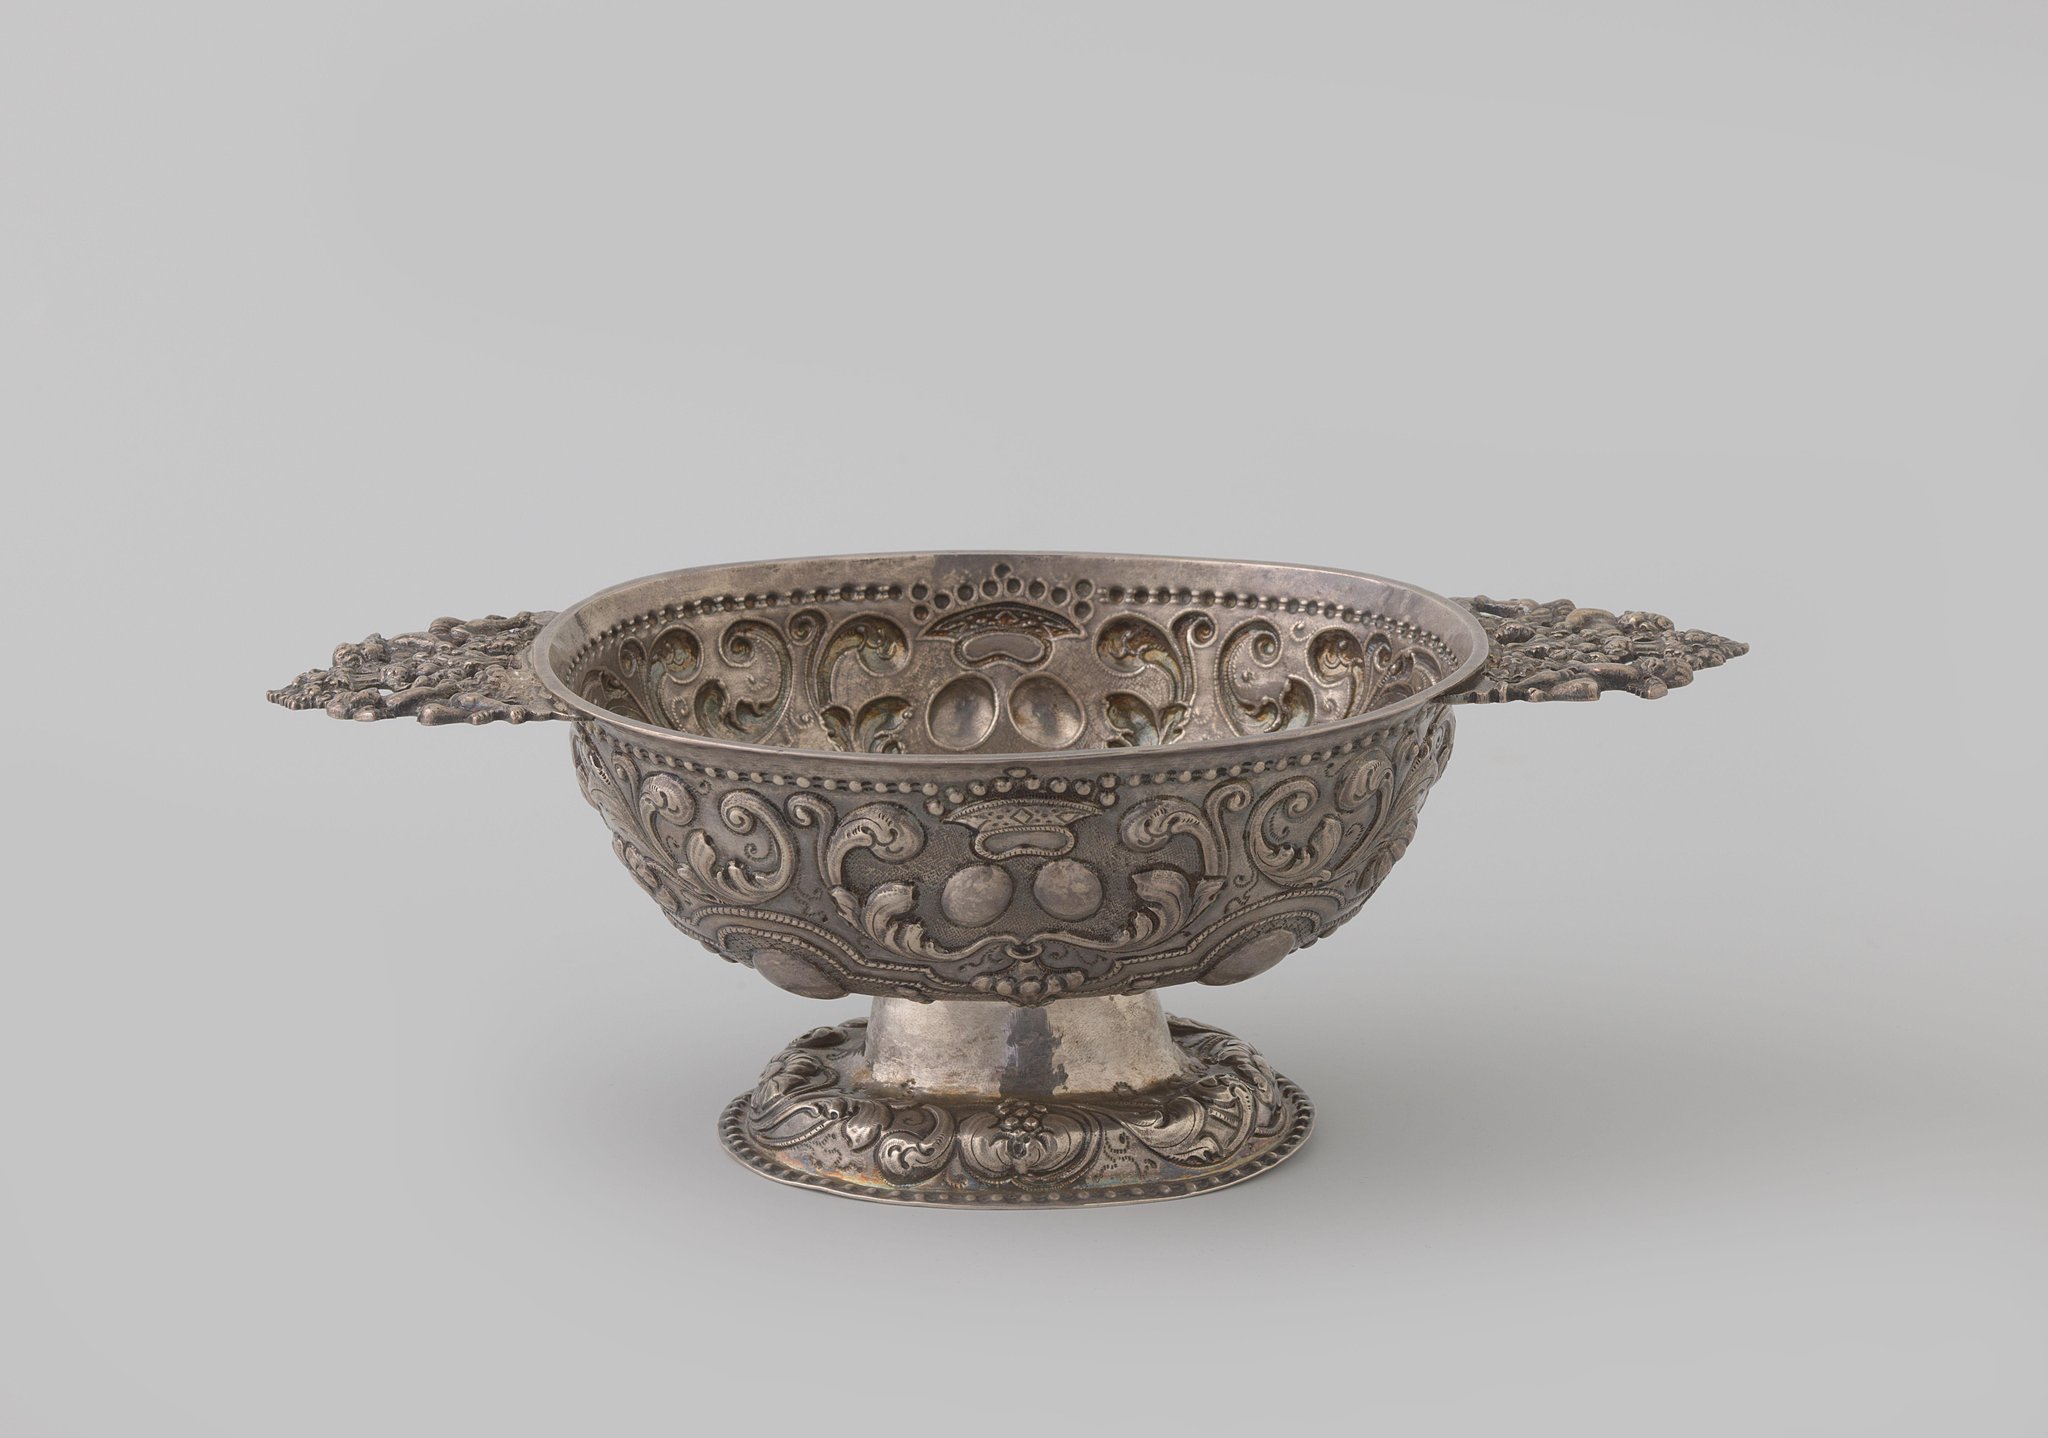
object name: brandy bowl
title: Brandewijnkom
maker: Anonymous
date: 1764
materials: silver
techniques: casting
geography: sneek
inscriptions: mark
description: Brandewijnkom van gedreven zilver. De ovale cuppa staat op een gewelfde voet. De gegoten horizontale oren zijn opengewerkt en vertonen een bloemenmand met engeltjes.